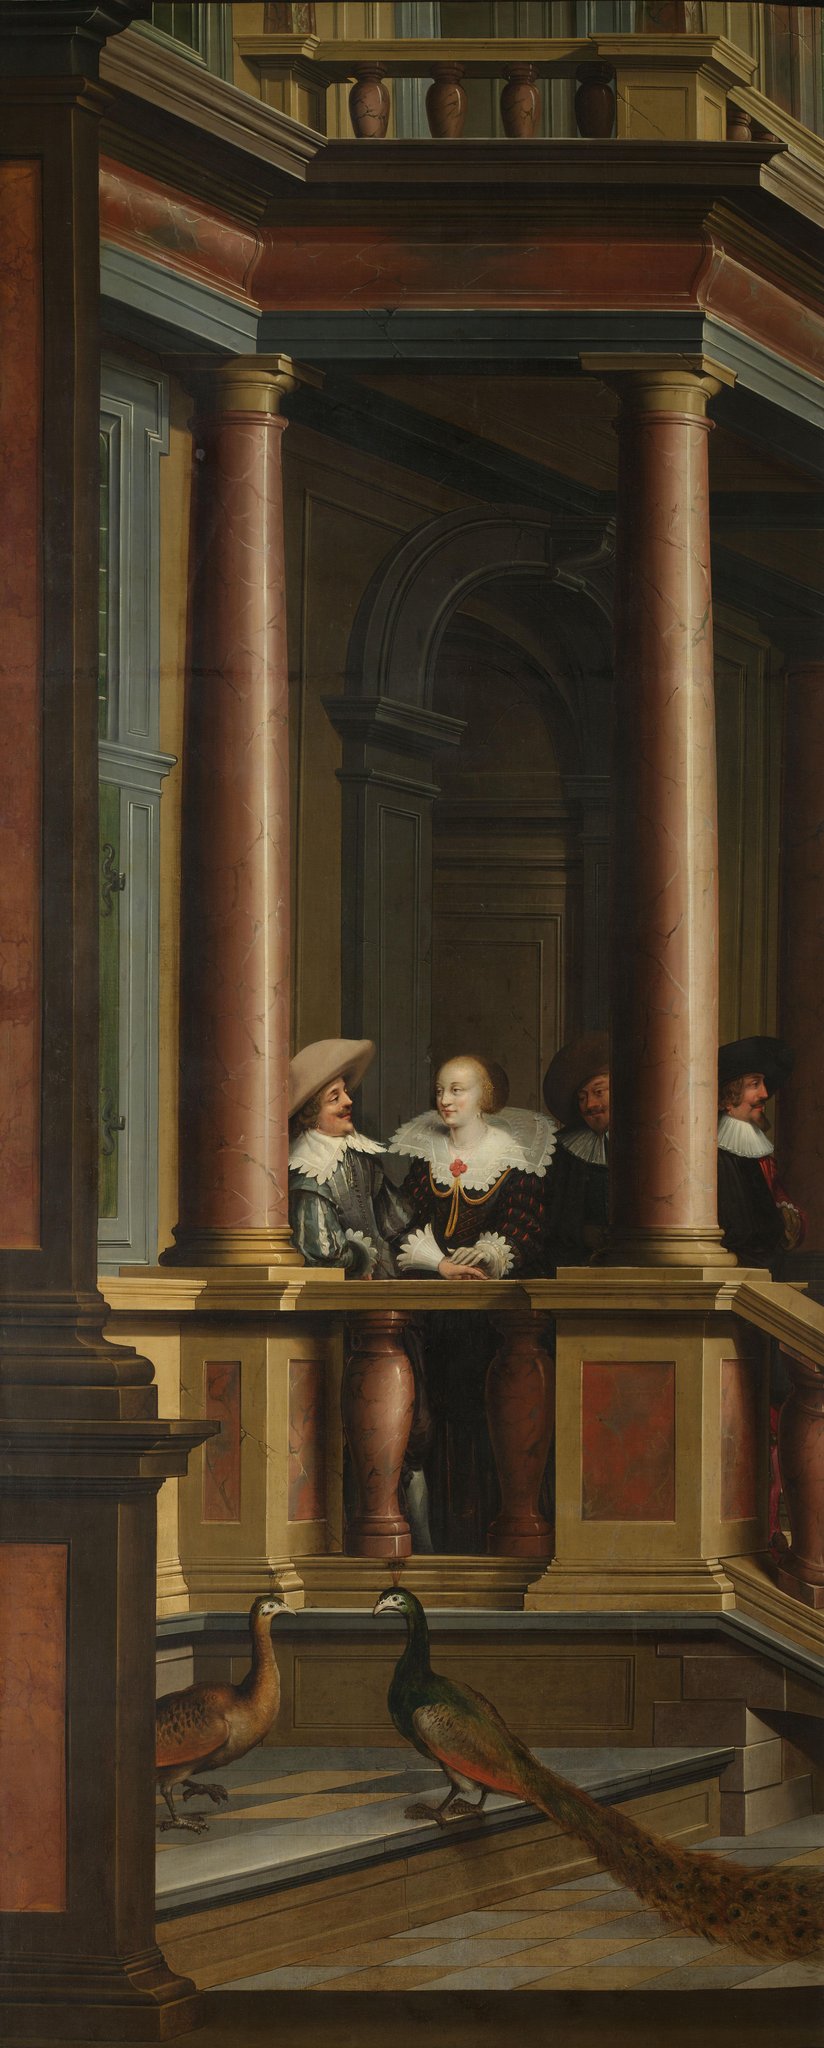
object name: painting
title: A Seven-Part Decorative Sequence: An Outdoor Stairway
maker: dirck van delen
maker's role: painter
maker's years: 1604-1671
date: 1630-1632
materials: canvas, oil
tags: palace, ornamental birds: peacock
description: Onderdeel van een zevendelige kamerbeschildering in vijf stukken met afbeeldingen van een interieur, twee galerijen en twee buitentrappen, bevolkt met talrijke personen. Het betreft hier de linkerhelft van de voorstelling van een buitentrap. Bij de trap staan verschillende elegante personen, onderaan twee pauwen. (Zie voor de andere helft SK-A-3939)